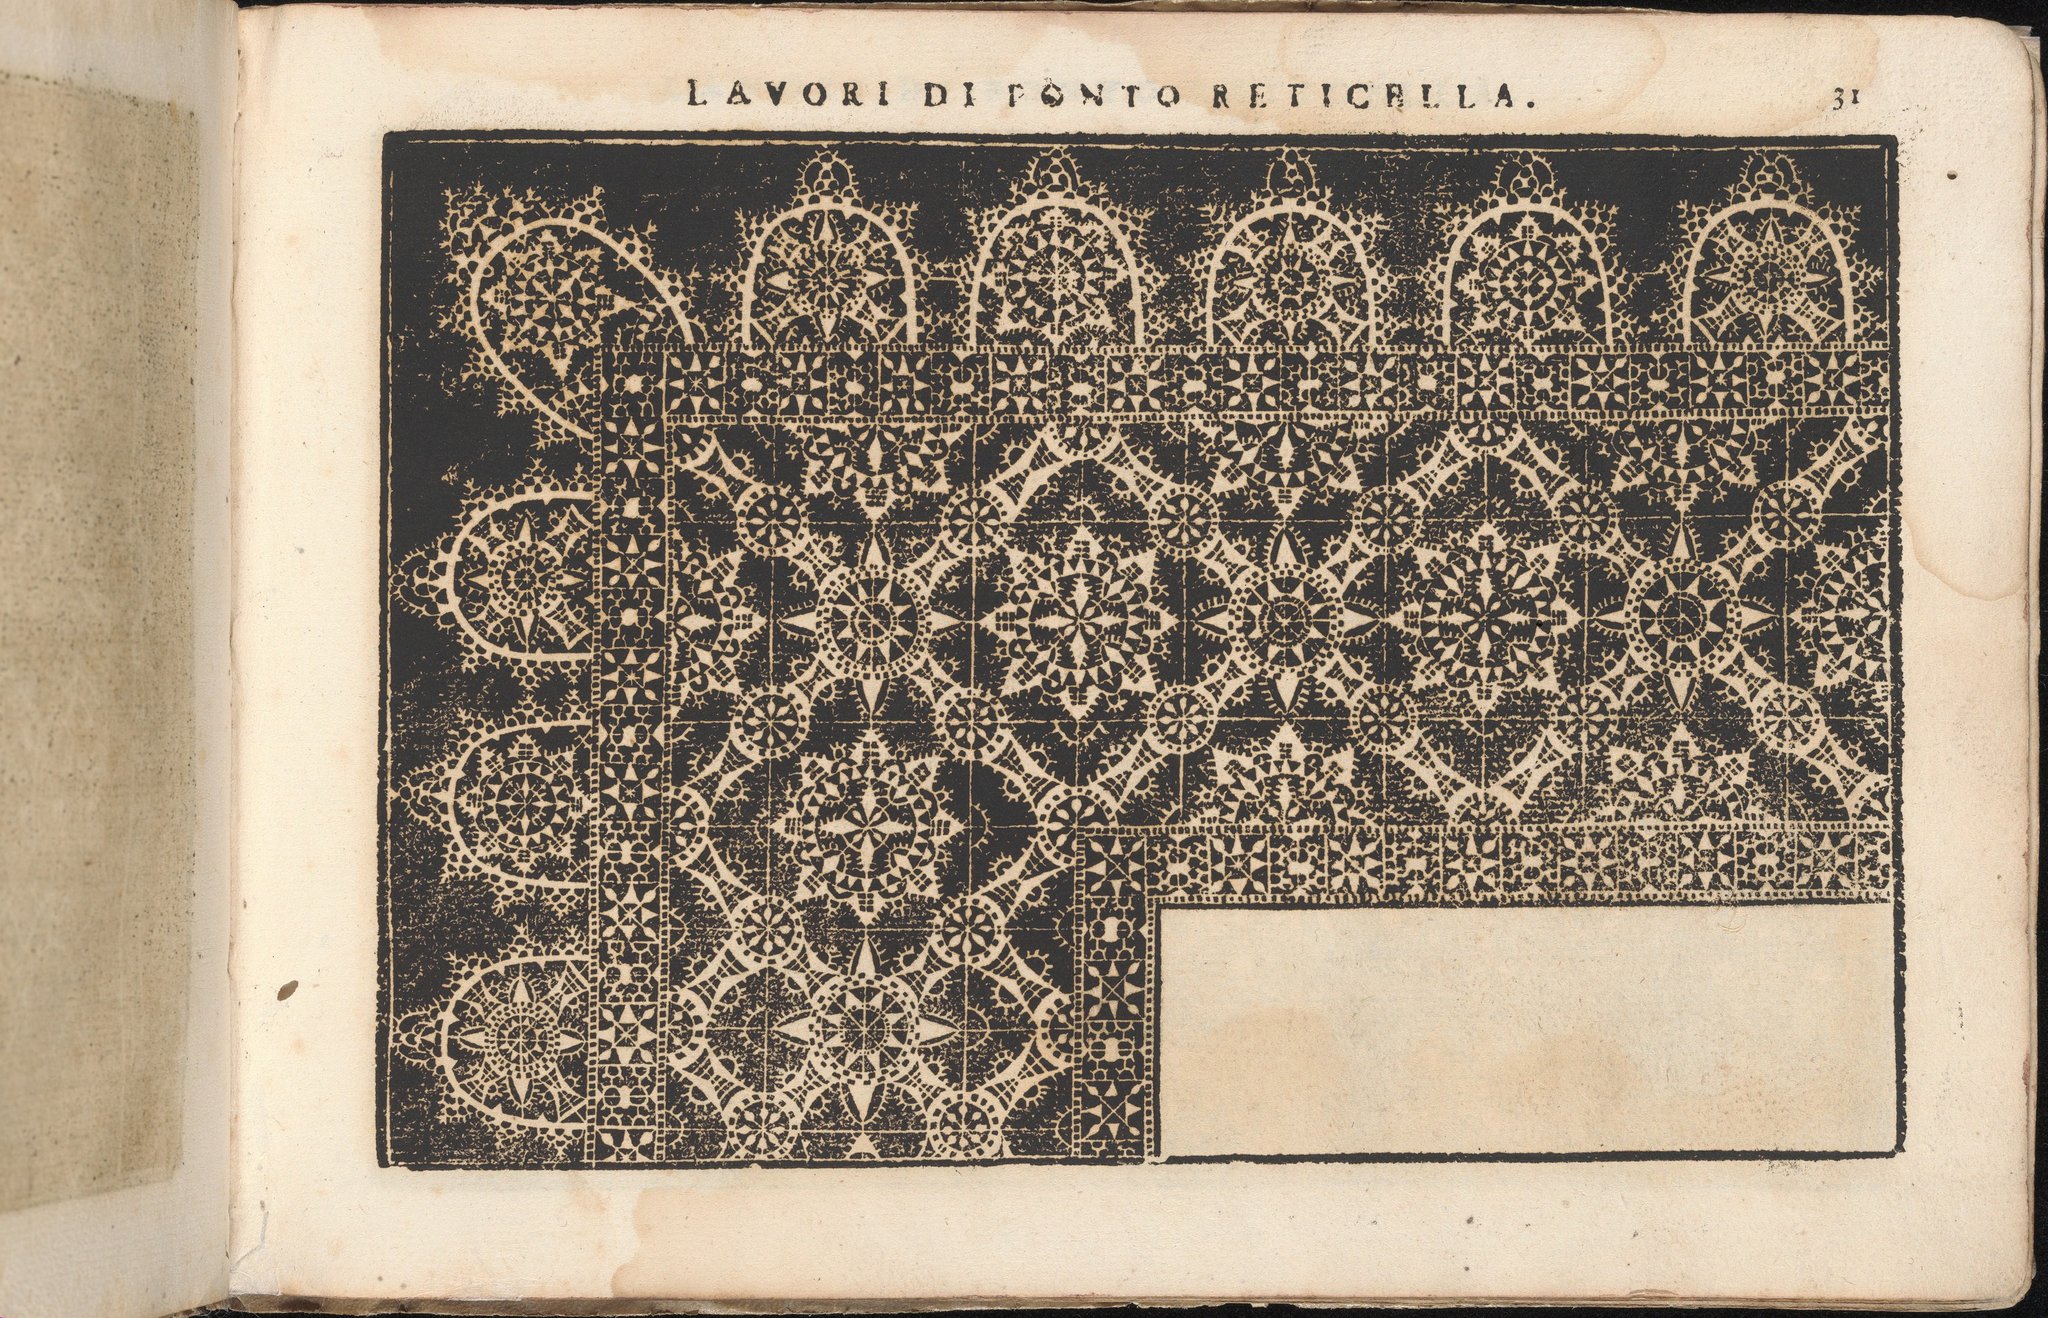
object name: book print ornament architecture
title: Teatro delle Nobili et Virtuose Donne..., page 33 (recto)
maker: isabella catanea parasole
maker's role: author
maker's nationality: italian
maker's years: 1565-1625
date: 1616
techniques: engraving, woodcut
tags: ornament